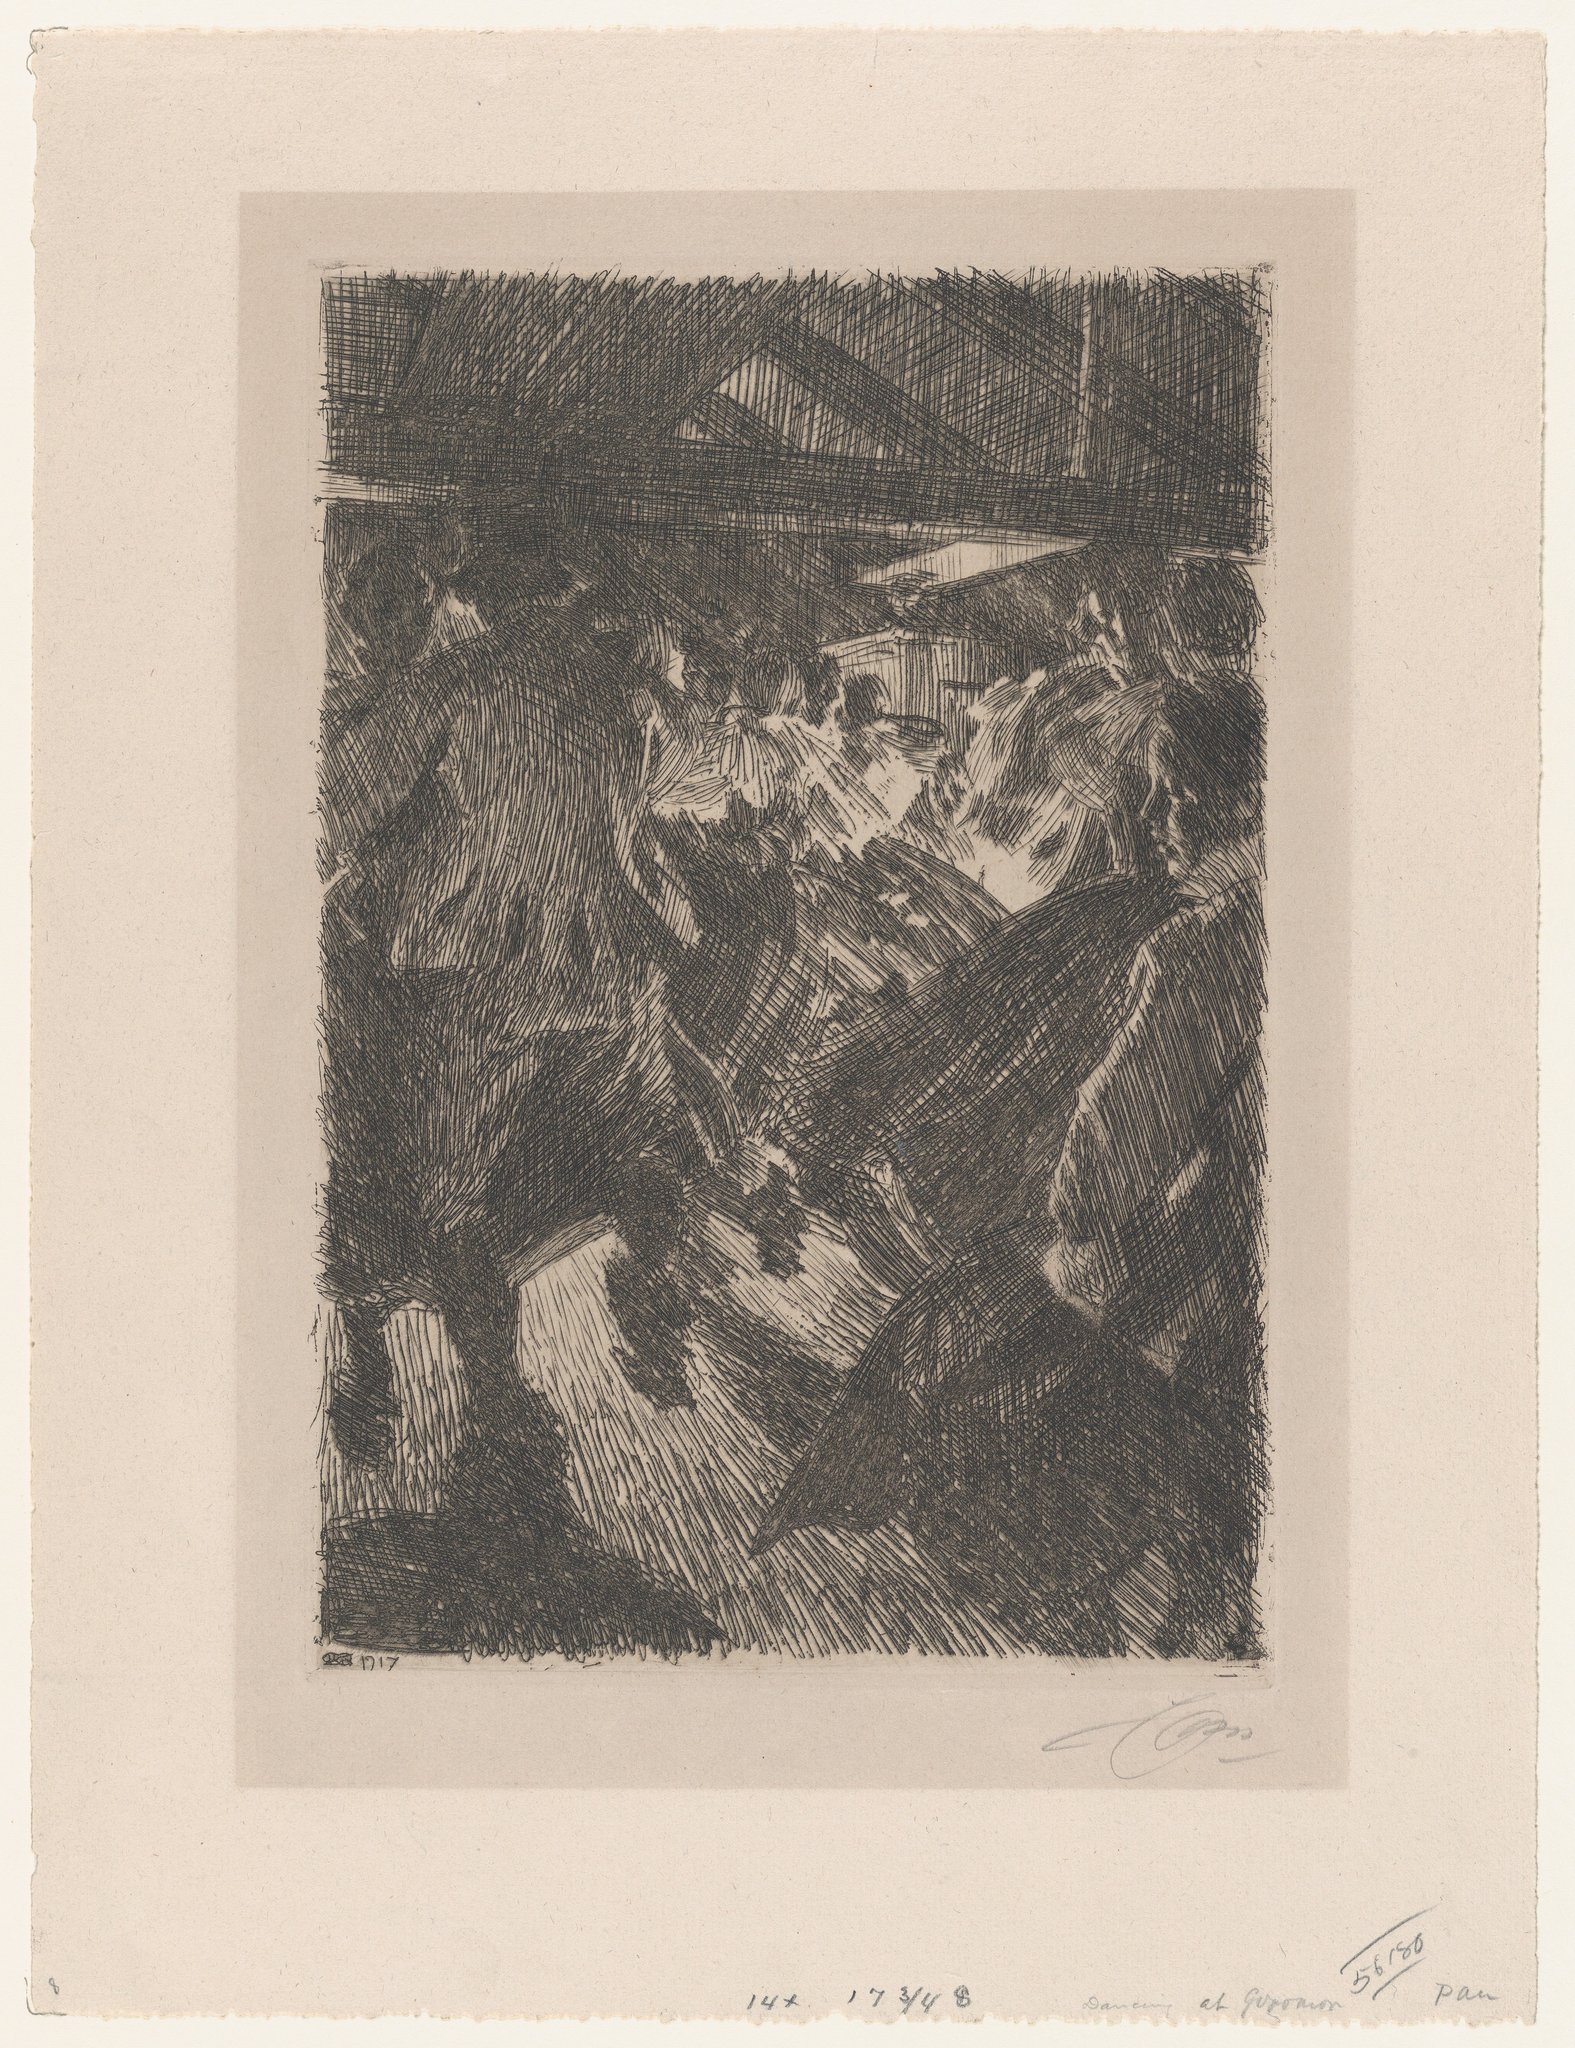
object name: print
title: Gopsmor Cottage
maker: anders zorn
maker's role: artist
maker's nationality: swedish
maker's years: 1860-1920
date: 1917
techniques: etching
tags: human figures,houses